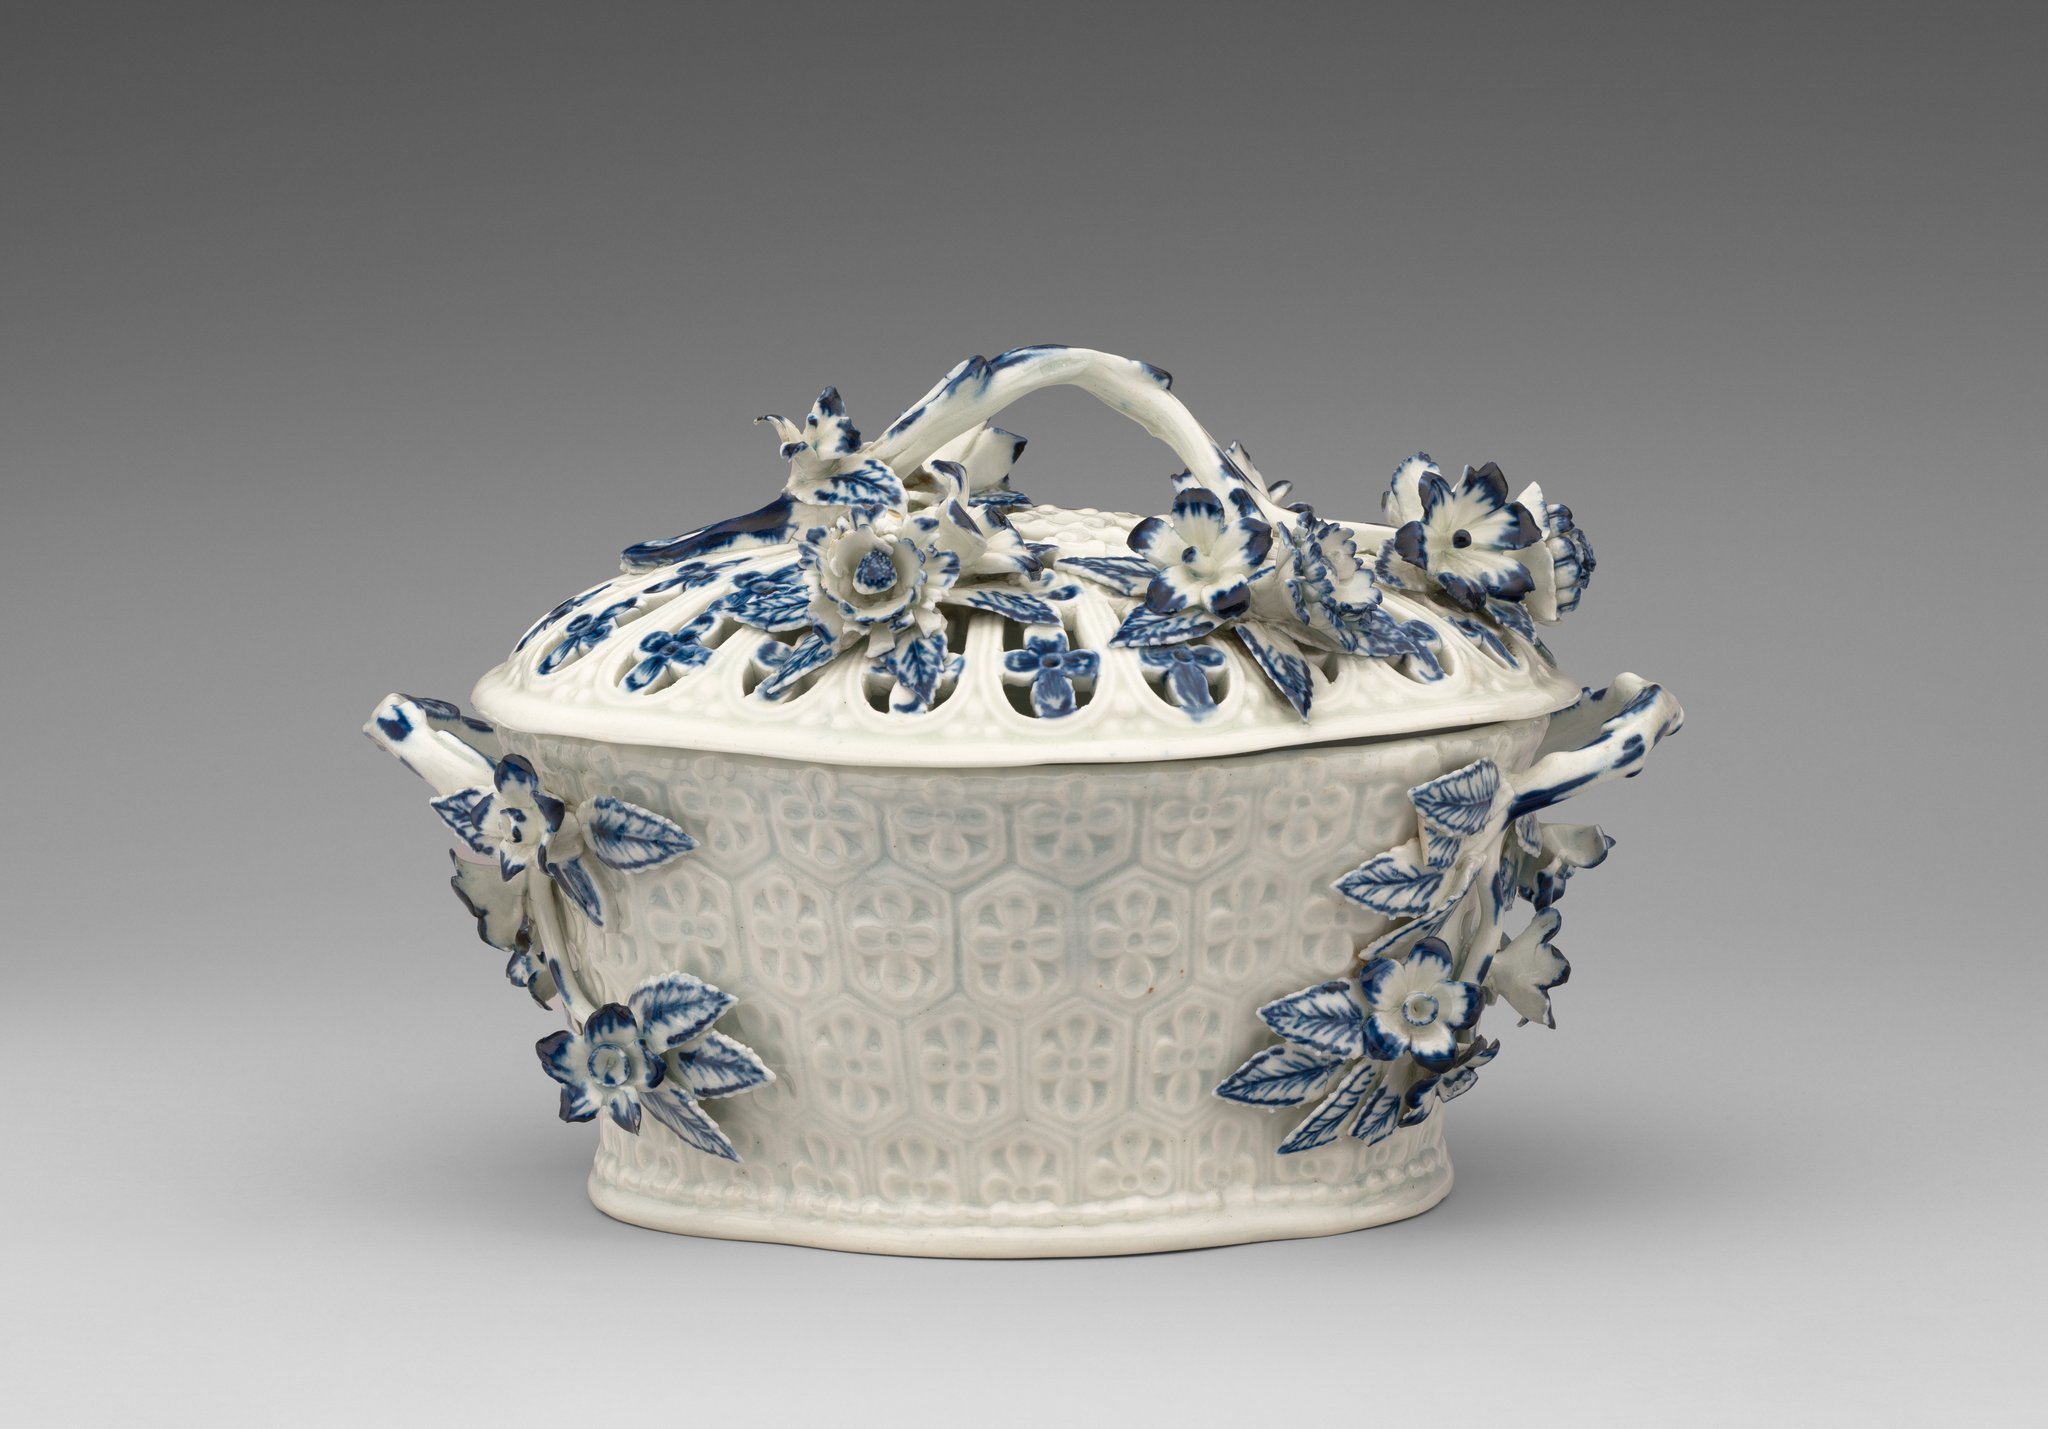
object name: dessert basket with cover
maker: worcester factory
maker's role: factory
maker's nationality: british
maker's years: 1751-2008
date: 1770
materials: soft paste porcelain